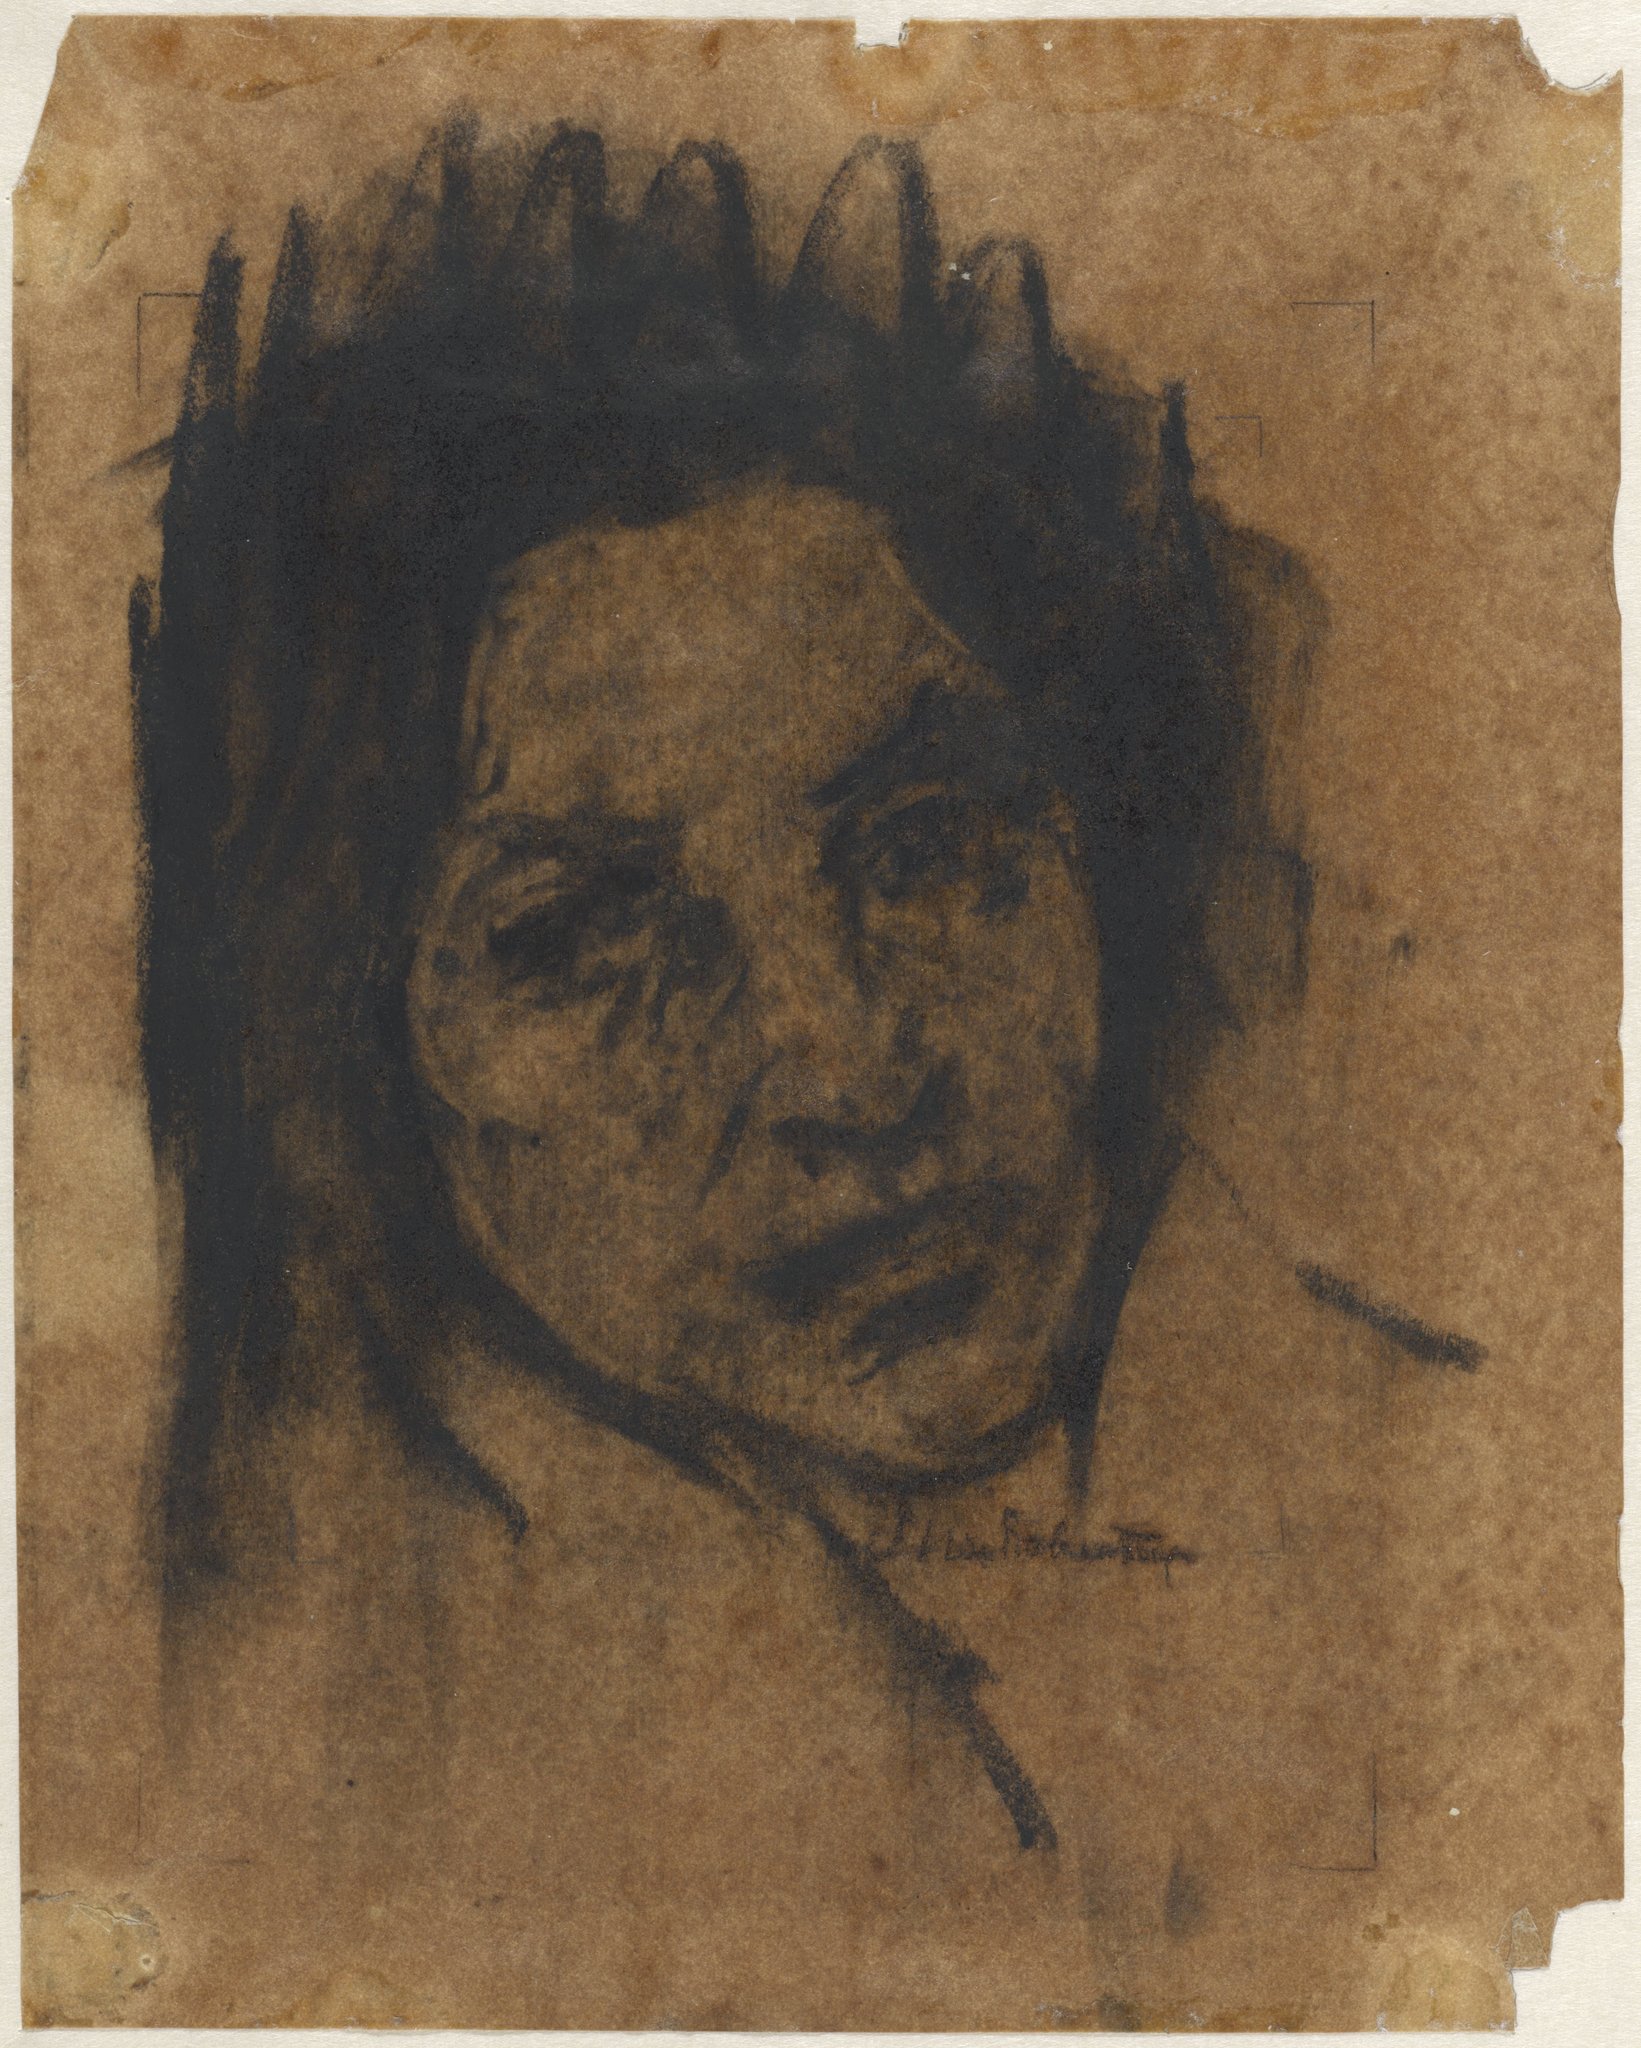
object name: drawing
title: Vrouwenhoofd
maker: suze robertson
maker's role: draughtsman, painter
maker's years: 1855-1922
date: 1865-1921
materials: chalk